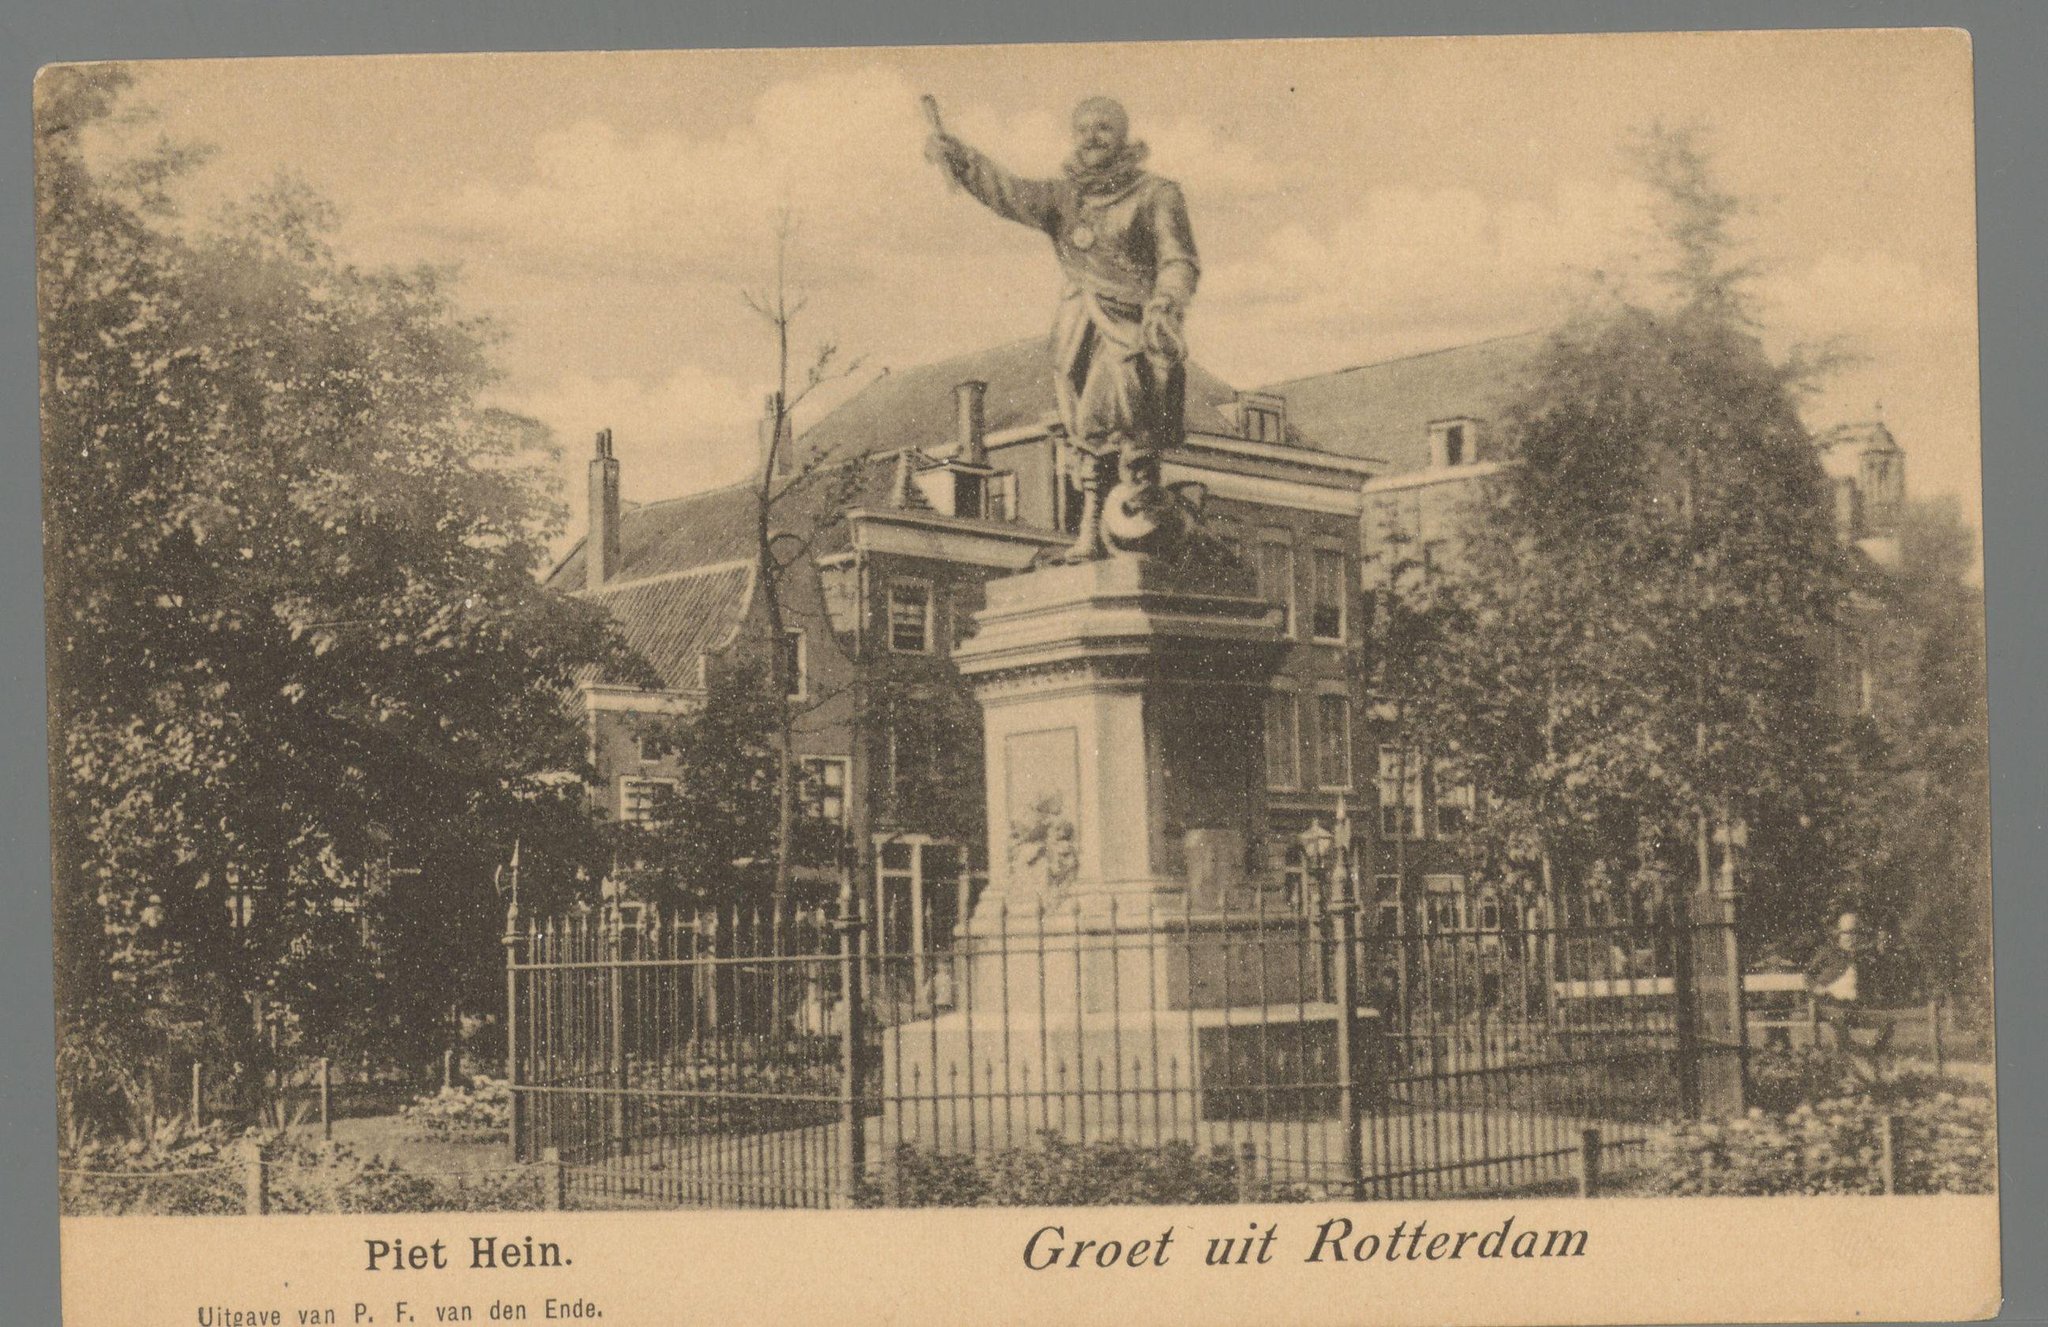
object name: photomechanical print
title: Piet Hein. Groet uit Rotterdam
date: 1897-1905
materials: cardboard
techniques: photograph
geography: rotterdam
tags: delfshaven, monument, statue, rotterdam